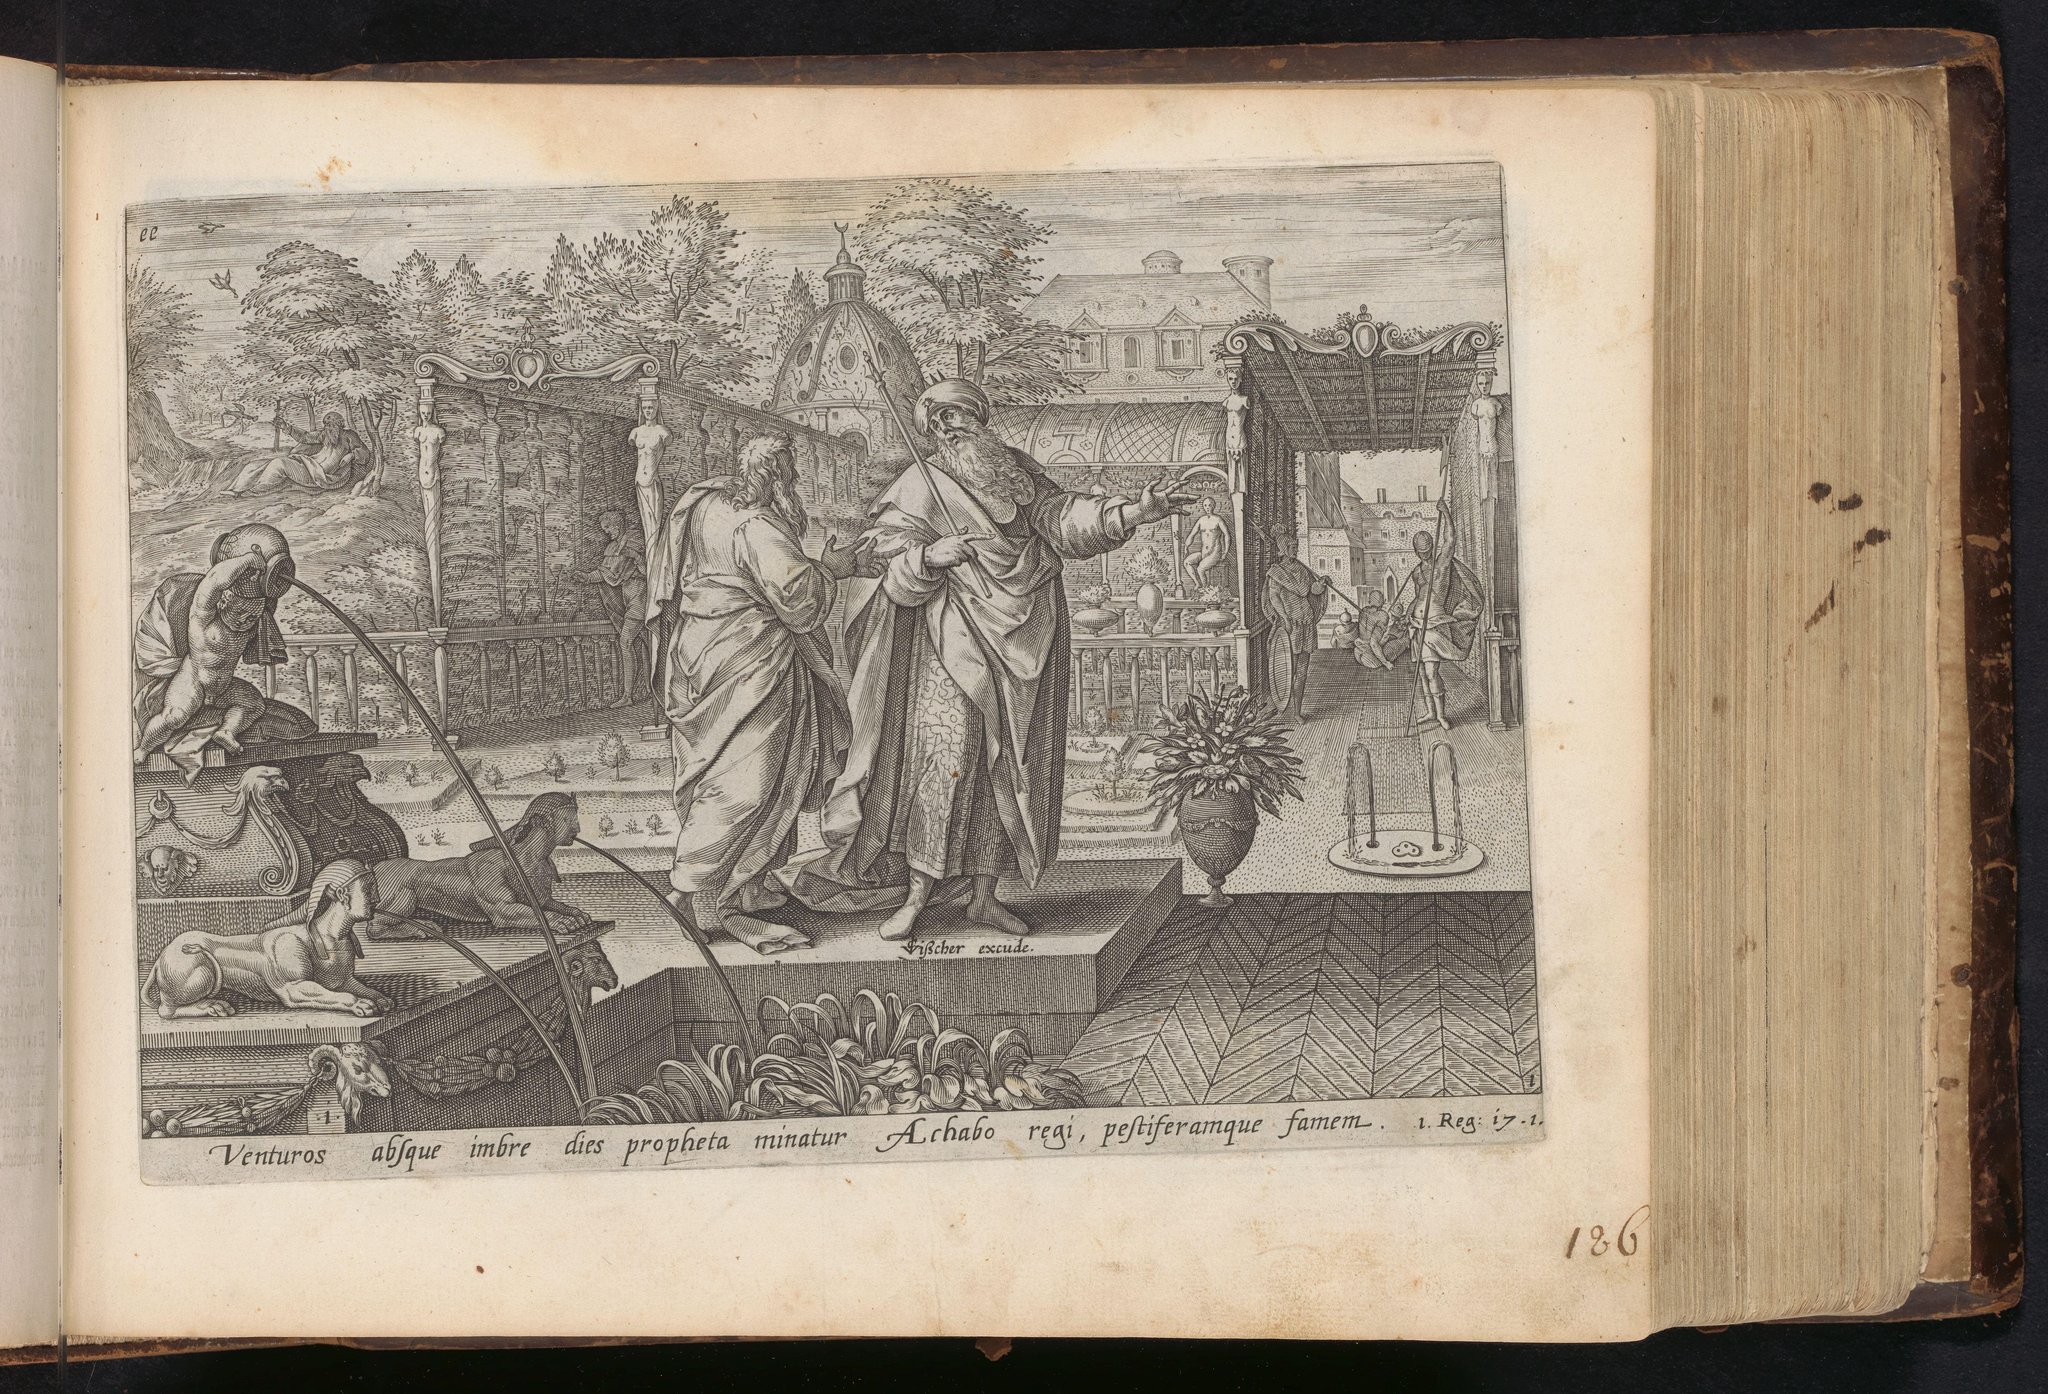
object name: album leaf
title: Geschiedenis van Elia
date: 1579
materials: paper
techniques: engraving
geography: alkmaar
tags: elijah announces to king ahab that god will bring a long drought in the land to avenge the apostasy of israel, elijah fed by the raven(s): while the prophet is living by the brook, ravens bring him food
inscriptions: number: ‘186’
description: Elia voorspelt aan koning Achab dat er een aantal jaar geen dauw of regen zal vallen. Links op de achtergrond zit Elia bij de beek Kirit waar raven hem van voedsel voorzien. Onder de voorstelling een verwijzing in het Latijn naar de Bijbeltekst in 1 Kon. 17:1. Deze prent maakt deel uit van een album.